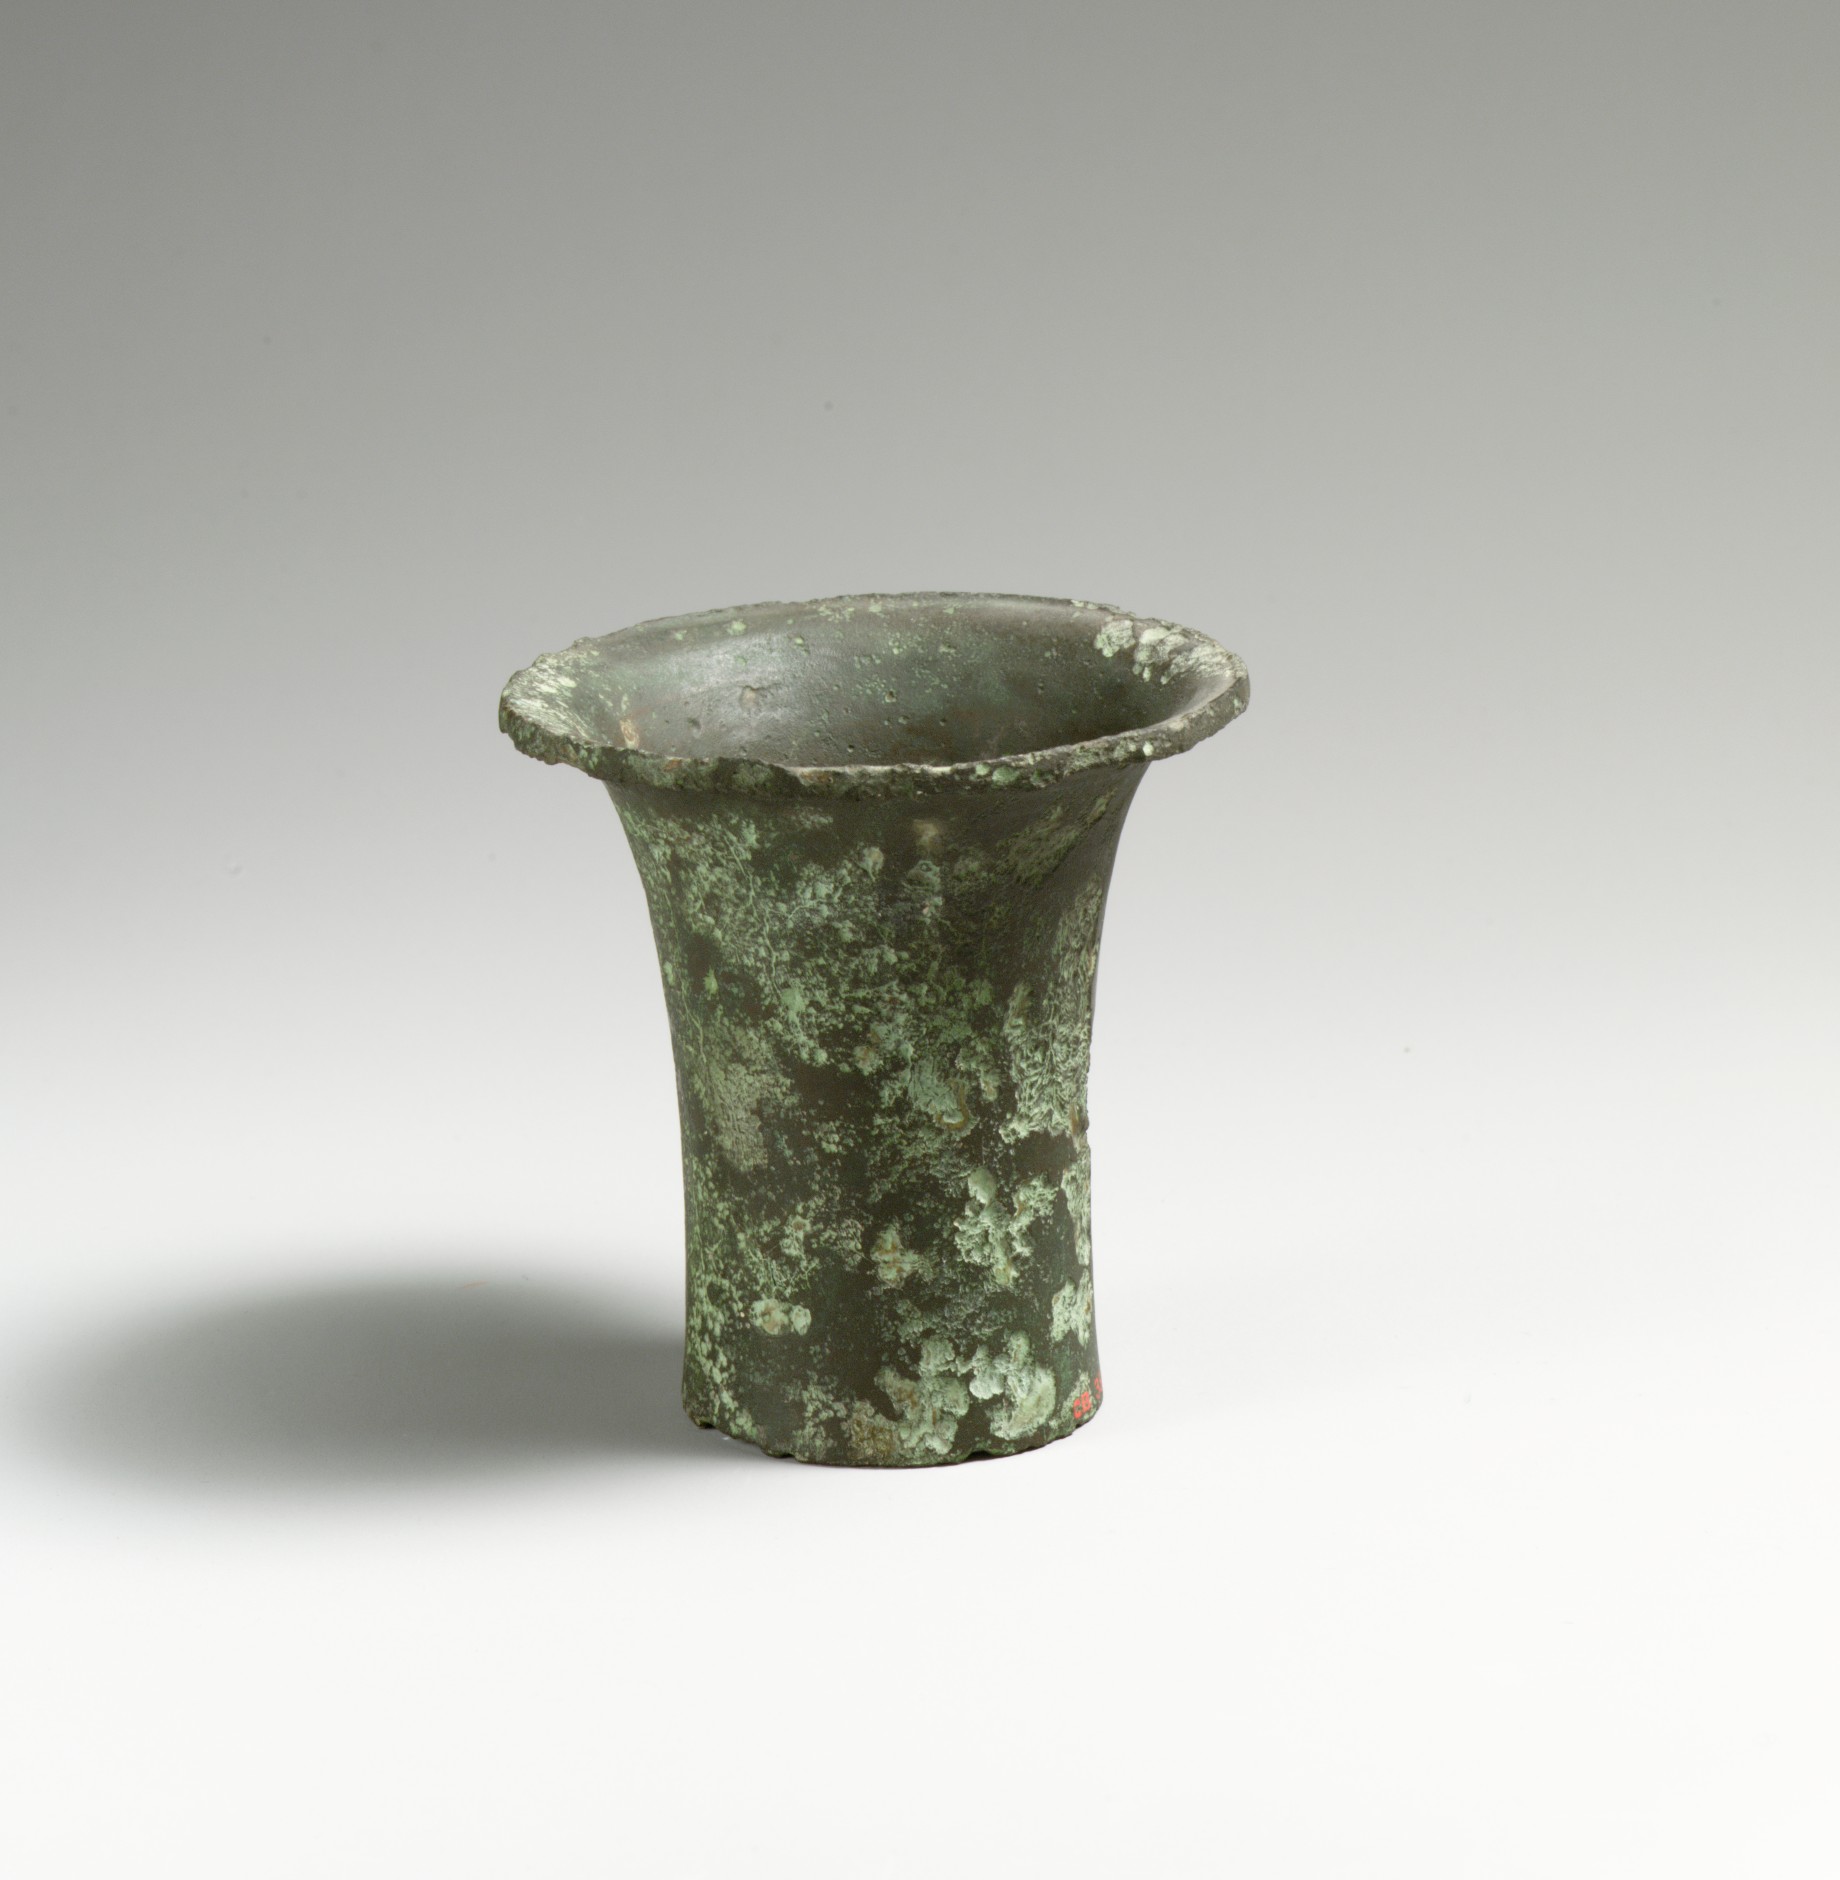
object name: cup from a torch holder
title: Cup from a torch-holder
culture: cypriot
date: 3900 BCE-100 CE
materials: bronze